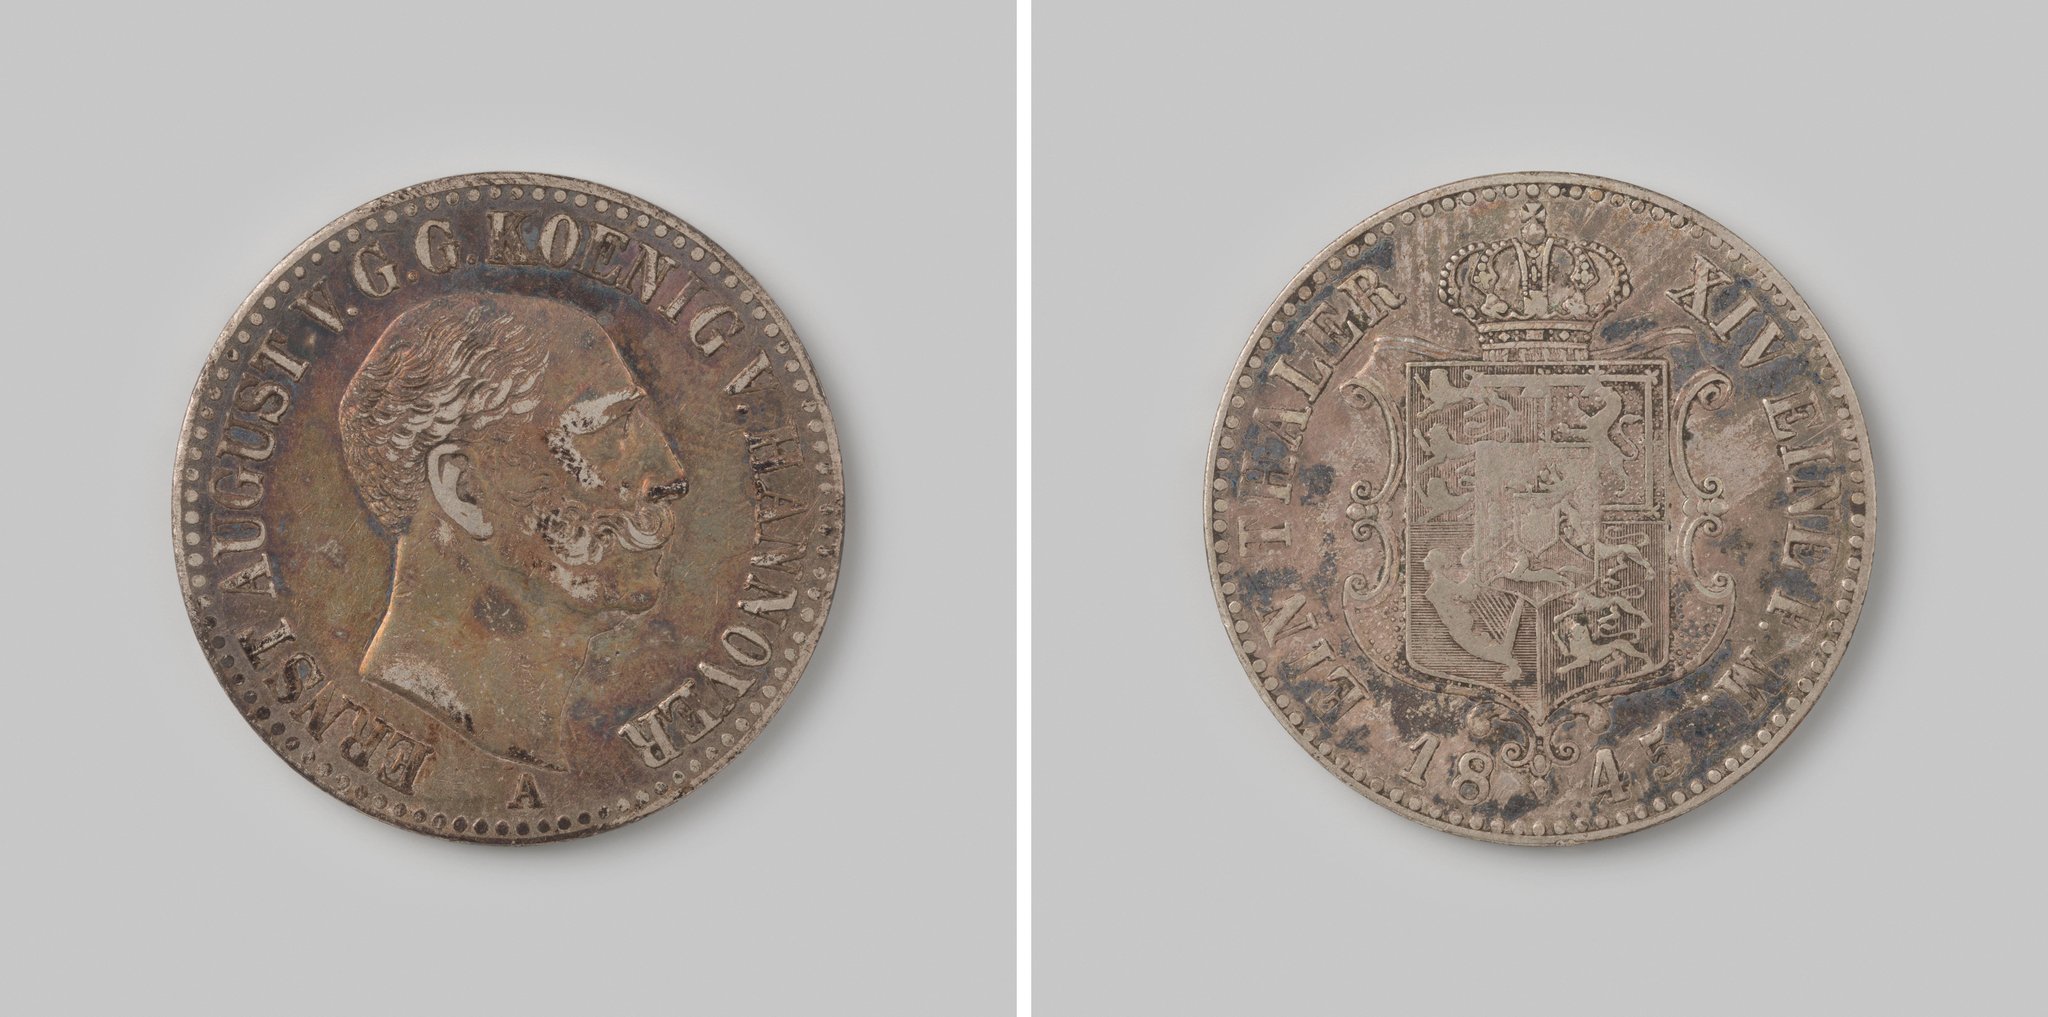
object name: taler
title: Taler uit het koninkrijk Hannover van Ernst August, 1845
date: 1845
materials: silver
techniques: striking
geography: berlin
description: Zilveren munt. Voorzijde: hoofd van de koning naar rechts. Daaronder letter A. Keerzijde: gekroond versierd samengesteld wapenschild. Waarde-aanduiding in omschrift met onderaan jaartal. Randschrift.